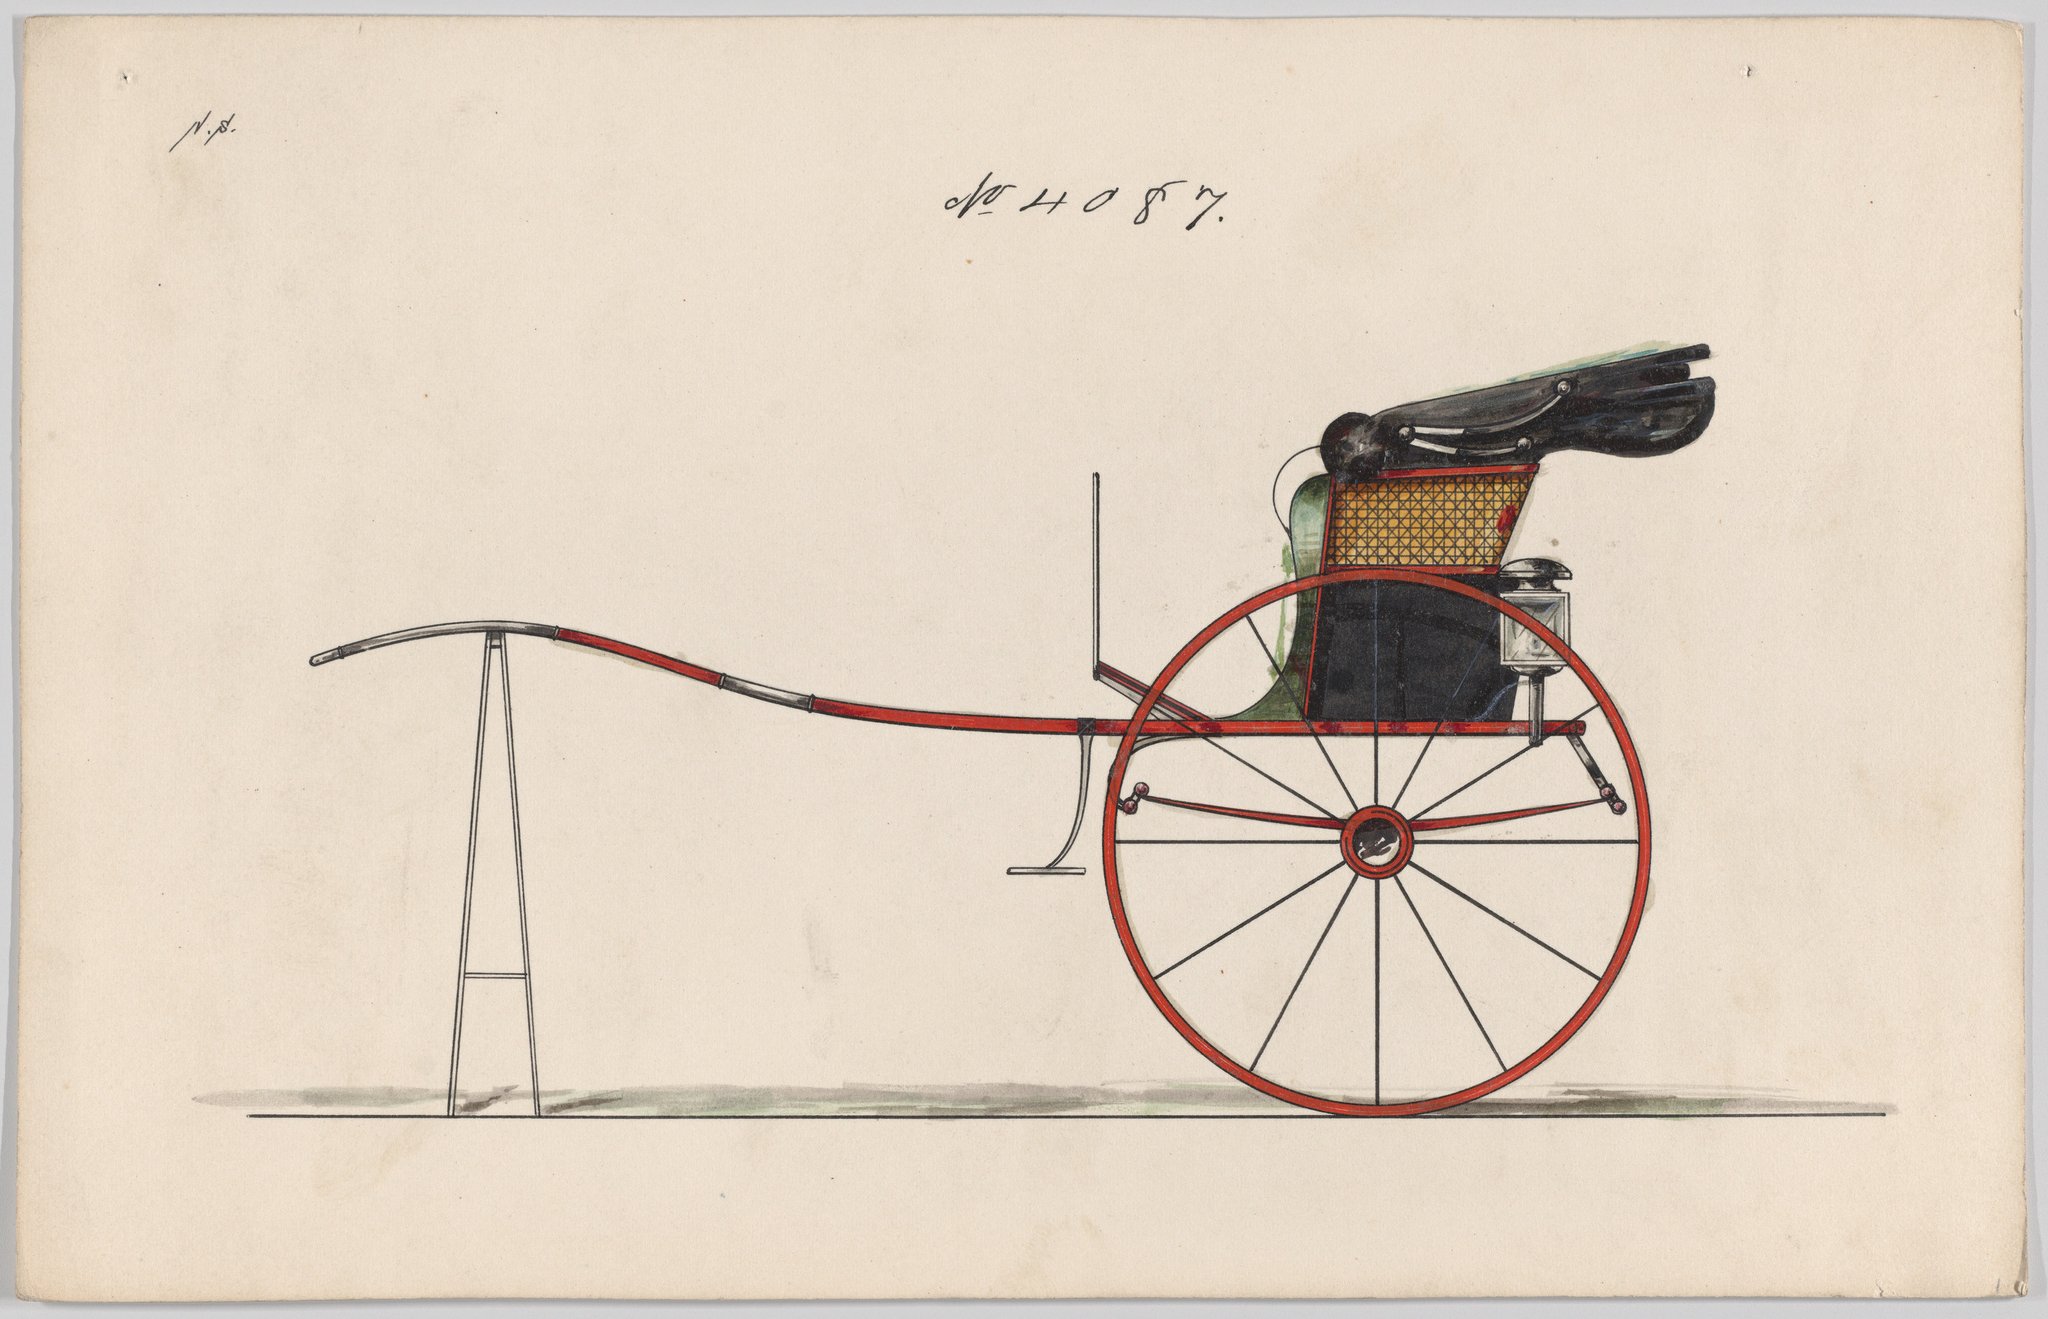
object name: drawing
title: Design for Dog Cart or 2 Wheeler, no. 4087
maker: brewster & co.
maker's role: manufacturer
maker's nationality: american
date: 1890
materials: gouache, gum arabic, ink, watercolor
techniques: pen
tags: carriages